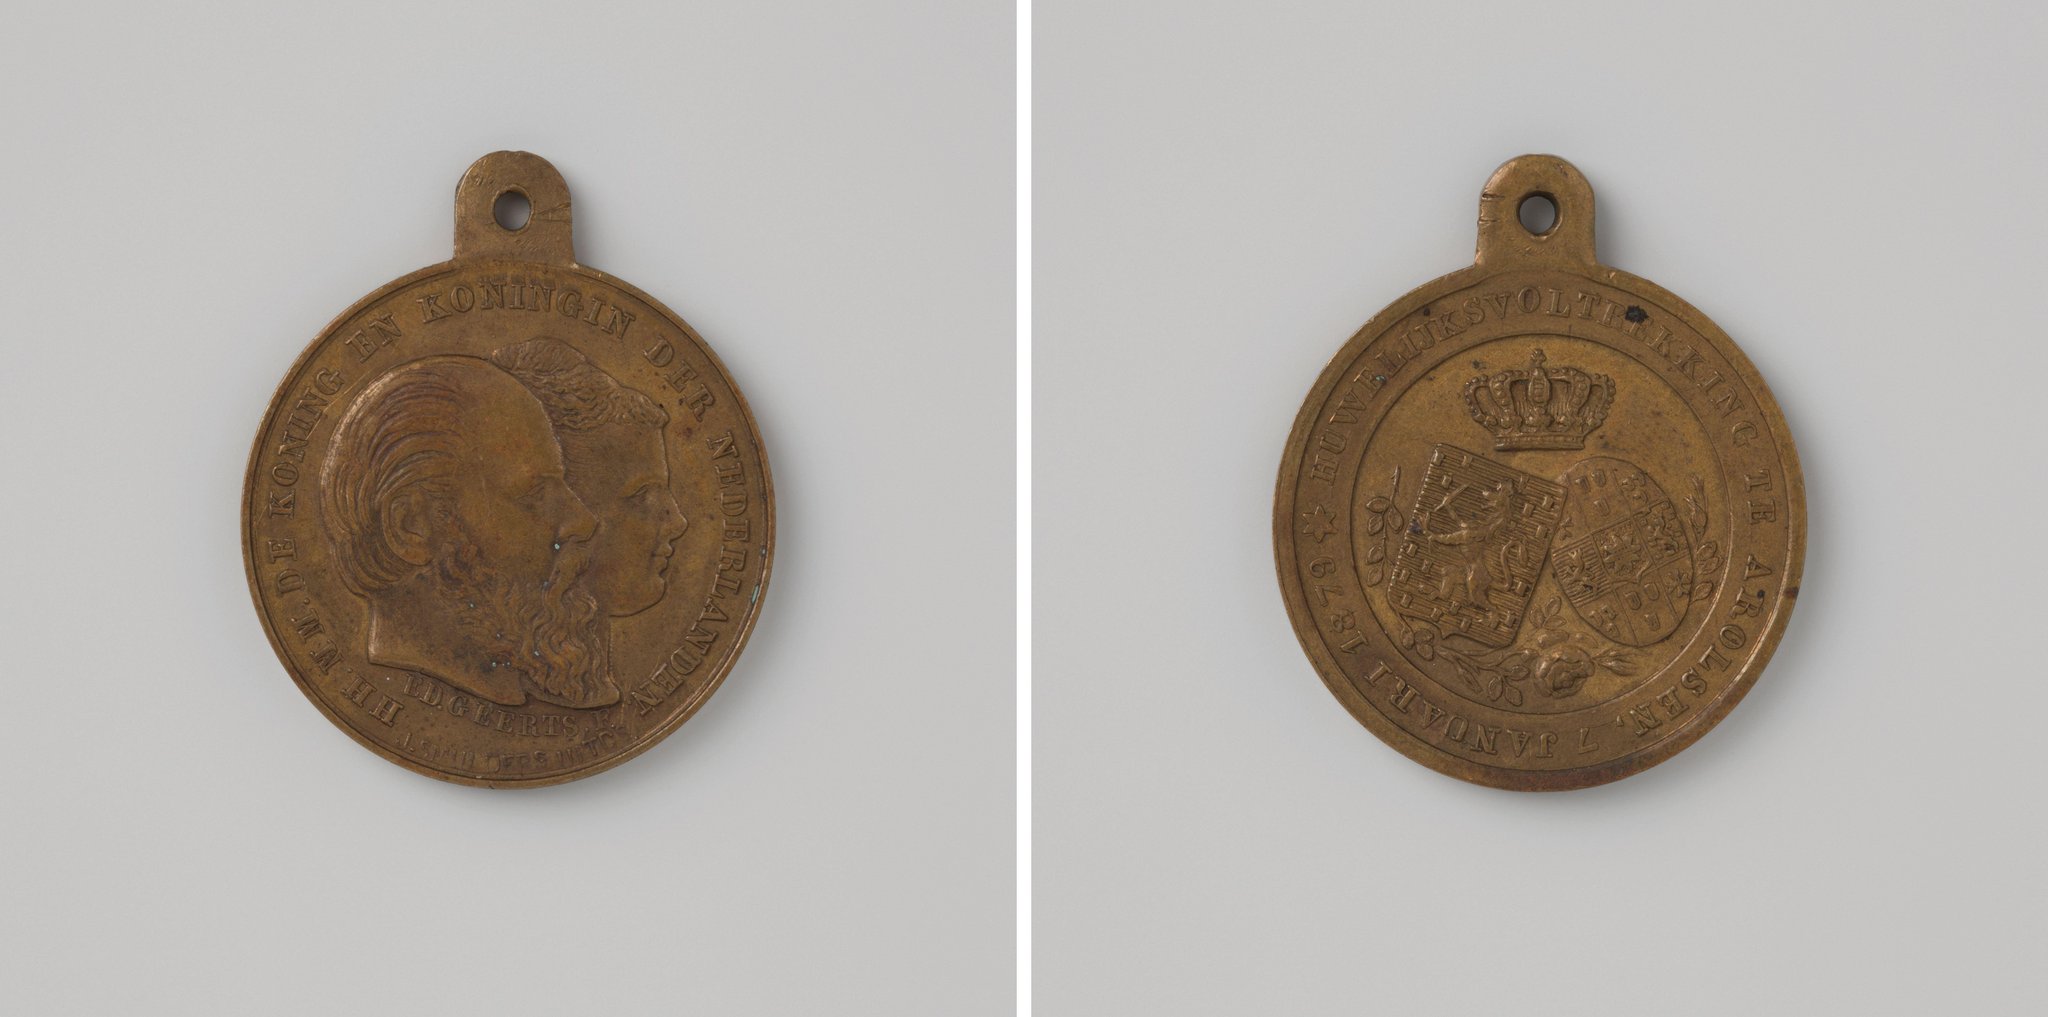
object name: history medal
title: Huwelijk van Koning Willem III en Emma van Waldeck Pyrmont 1879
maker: edouard louis geerts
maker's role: medailleur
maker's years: 1846-1889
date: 1879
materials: brass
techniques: striking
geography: the hague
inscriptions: circumscription: ‘HH. MM. DE KONIG EN KONINGIN DER NEDERLANDEN’, signature: ‘ED. GEERTS F.’, signature: ‘J. SMULDERS UITGS.’, circumscription: ‘HUWELIJKSVOLTREKKING TE AROLSEN 7 JANUARI 1879 (ster)’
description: Messing penning met draagoog, op de voorzijde de geconjugeerde bostbeelden van Willem III en Emma naar rechts met omschrift, op de keerzijde onder één kroon de wapenschilden van Nederland en Waldeck-Pyrmont op een rozentak, met omschrift.